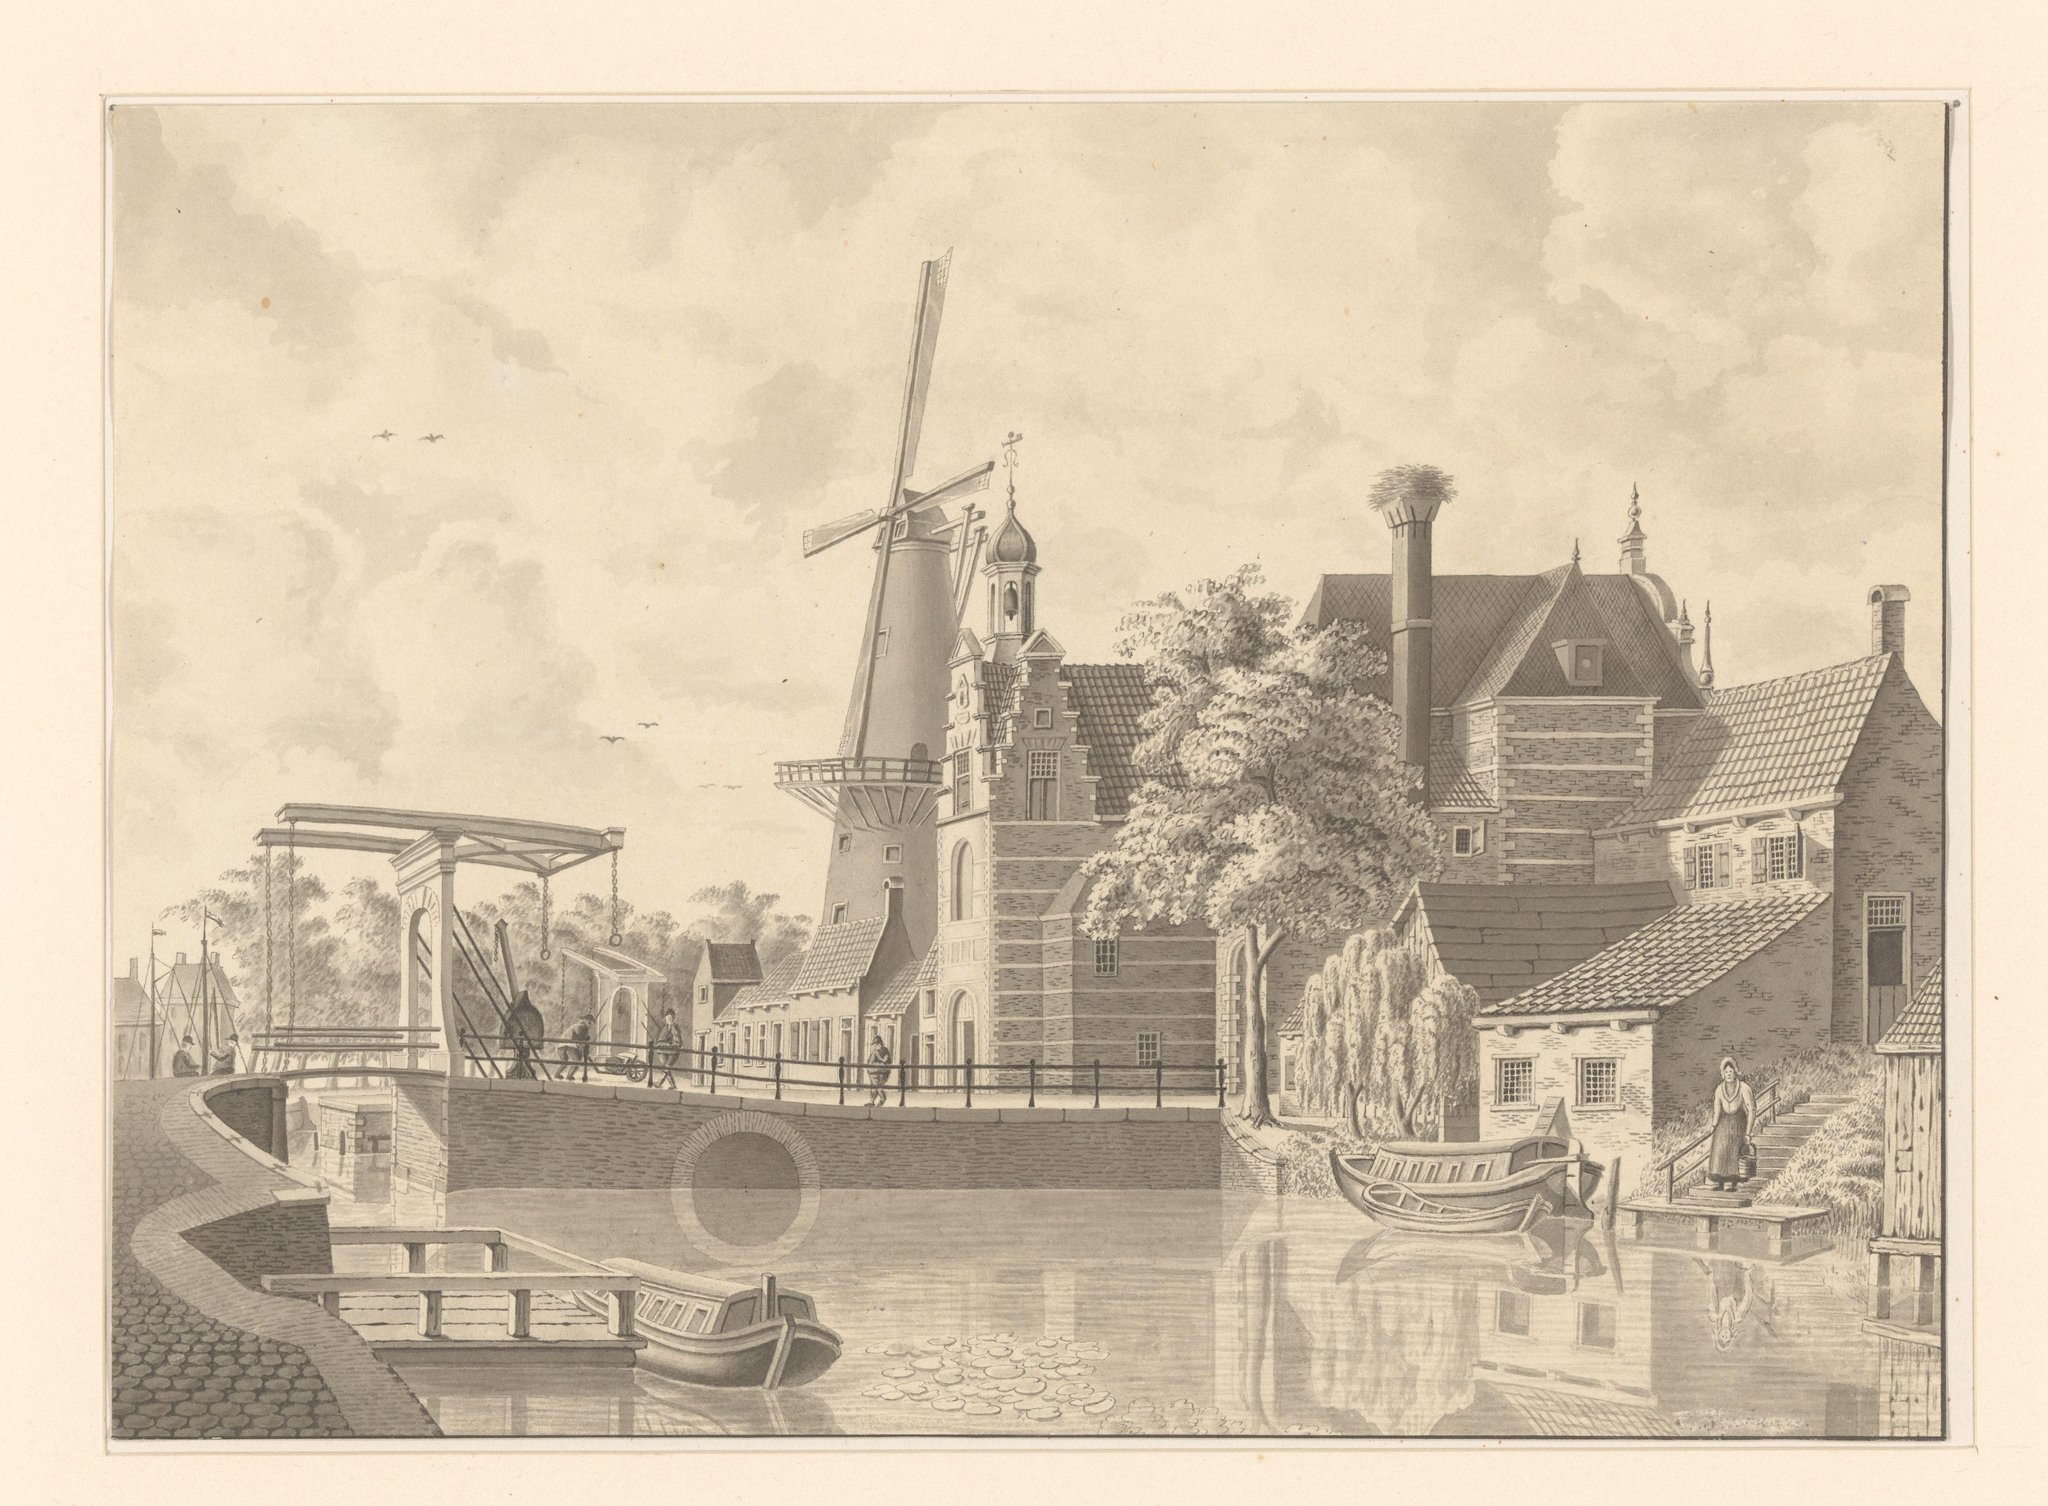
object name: drawing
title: Gezicht op de Rotterdamse Poort en Ketelpoort te Delft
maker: Anonymous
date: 1829-1840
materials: ink, paper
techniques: brush, pen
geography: netherlands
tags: canals, waters (in city), windmill, city-gate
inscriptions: collector's mark: Lugt 2233